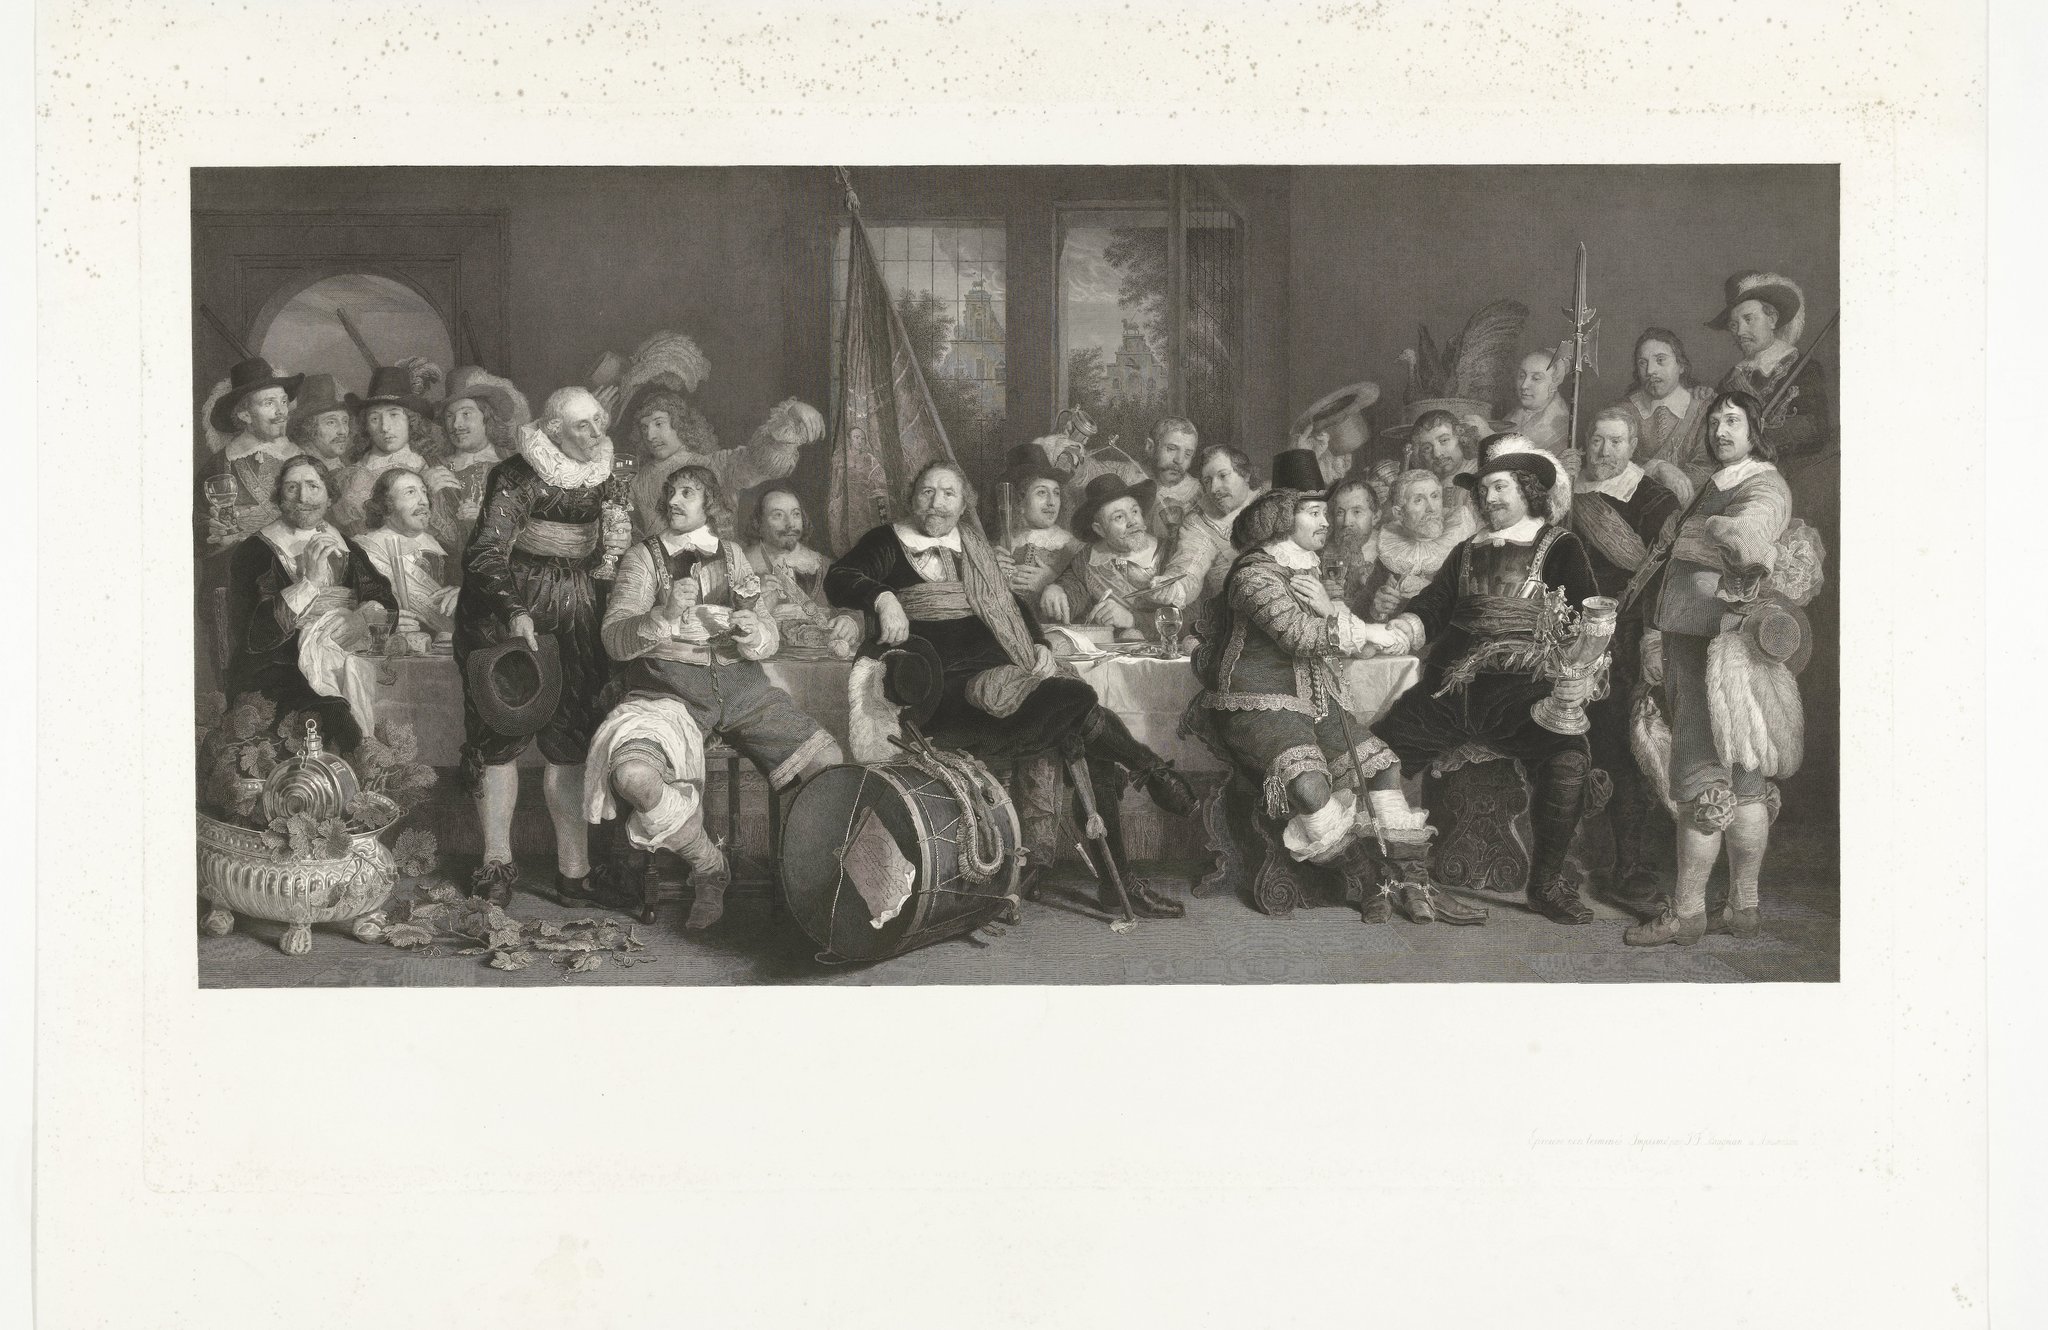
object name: print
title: De schuttersmaaltijd in de Voetboog- of St. Jorisdoelen te Amsterdam ter viering van het sluiten van de vrede van Munster, 18 juni 1648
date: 1854-1879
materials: paper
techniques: engraving, etching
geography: netherlands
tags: warfare; military affairs (+ citizen soldiery, civil guard, citizen militia), celebration meal, feast, banquet, festivities on events of national importance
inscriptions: inscription: ‘Epreuve non terminée Imprimé par J.F. Brugman a Amsterdam’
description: Het schilderij van de schuttersmaaltijd in de Voetboogdoelen of St. Jorisdoelen te Amsterdam ter viering van het sluiten van de vrede van Munster, 18 juni 1648. Voorgesteld zijn: kapitein Cornelis Jansz Witsen (met de zilveren drinkhoorn), luitenant Johan Oetgens van Waveren (die zijn hand schudt), de vaandrig Jacob Banningh (zittend naast de grote trommel), Dirck Claesz Thoveling en Thomas Hartog (sergeanten), Pieter van Hoorn, Willem Pietersz van der Voort, Adriaen Dirck Sparwer, Hendrick Calaber, Govert van der Mij, Johannes Calaber, Benedictus Schaeck, Jan Maes, Jacob van Diemen, Jan van Ommeren, Isaac Ooyens, Gerrit Pietersz van Anstenraadt, Herman Teunisz de Kluyter, Andries van Anstenraadt, Christoffel Poock, Hendrick Dommer Wz, Paulus Hennekijn, Lambregt van den Bos en Willem (de trommelslager). Op de grote trommel hangt een papier met een gedicht van Jan Vos. Door de openstaande ramen is de gevel van de brouwerij 'het Lam' aan de Singel zichtbaar. Rechts brengt een vrouwen een kalkoenpastei binnen. Op tafel staan tinnen borden, roemers en andere glazen. Links staat op de vloer een grote metalen koeler met een wijnvat.